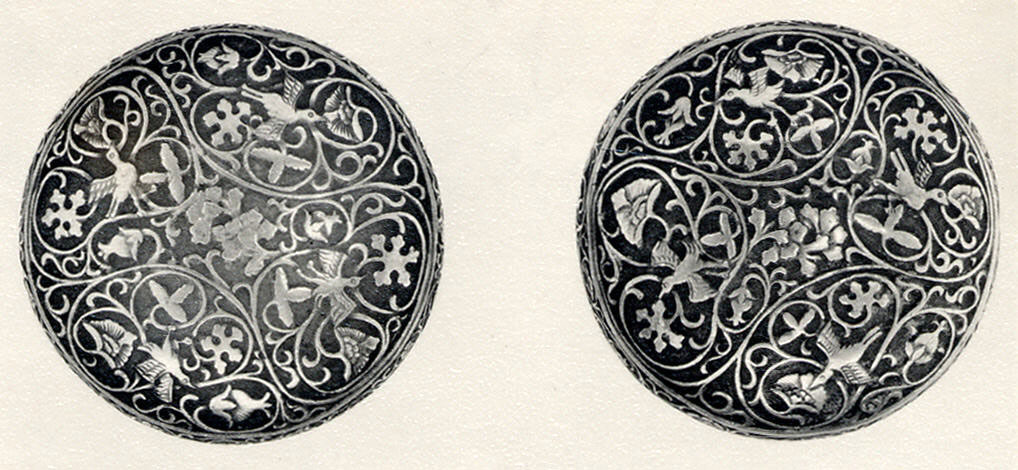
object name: box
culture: chinese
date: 701-800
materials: silver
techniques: gilding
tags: birds,flowers